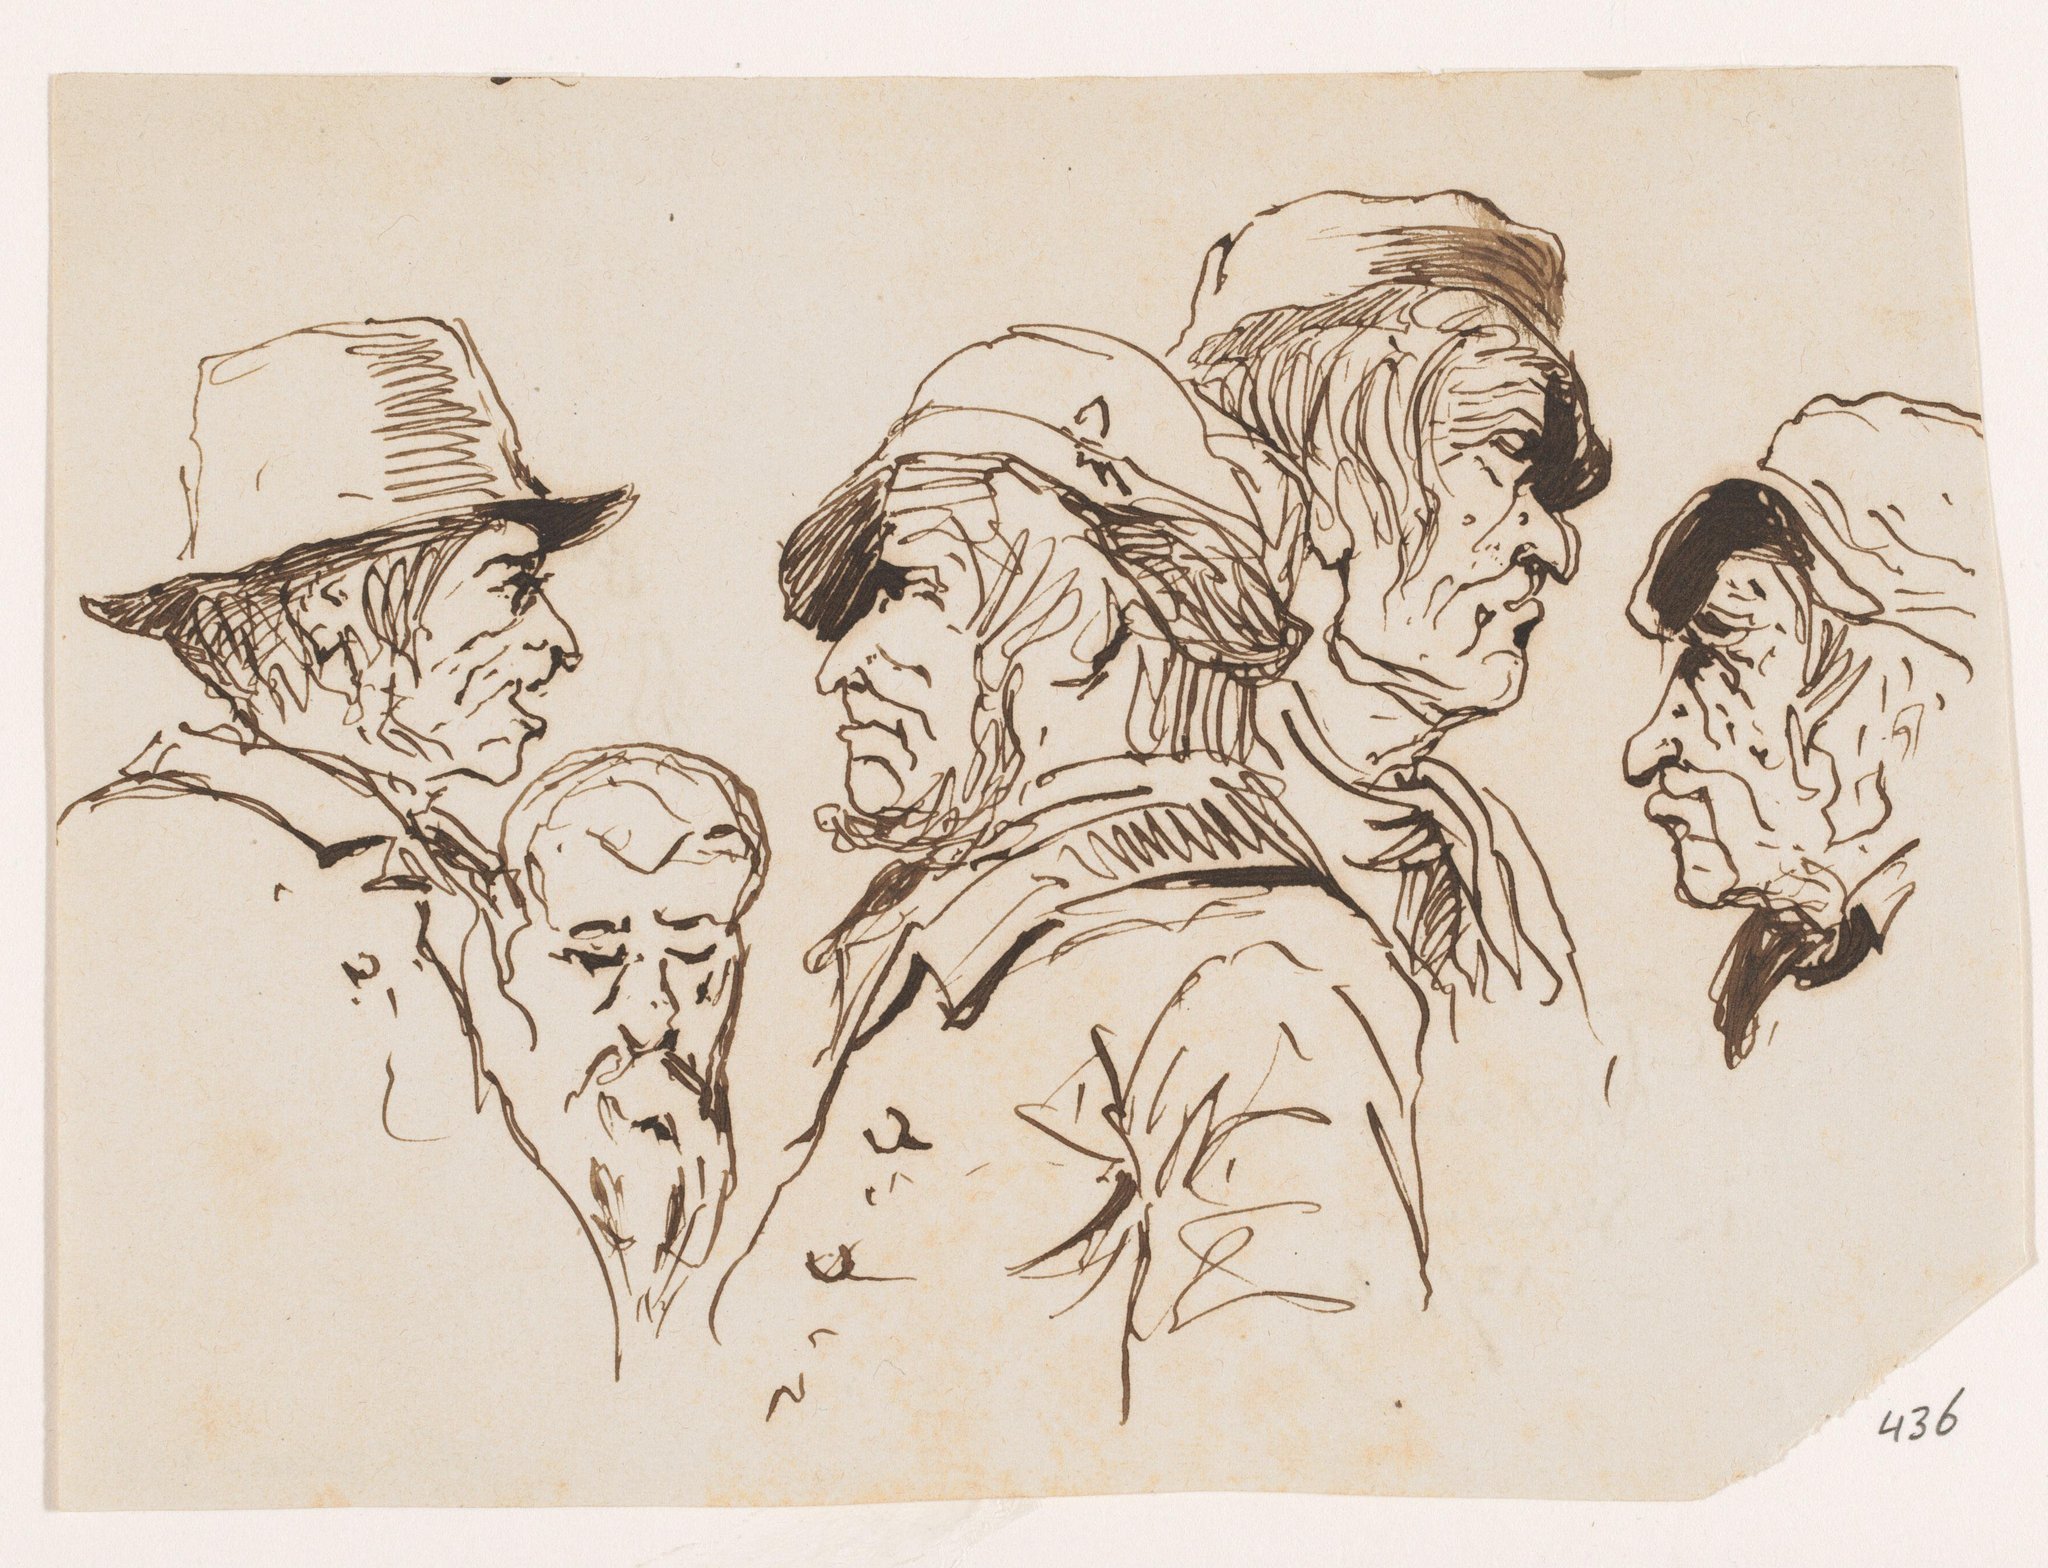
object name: drawing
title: Vijf koppen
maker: johannes tavenraat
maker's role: draughtsman, painter, print maker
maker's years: 1809-1881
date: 1869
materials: ink, paper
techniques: pen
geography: schwerin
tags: caricatures (human types)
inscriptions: collector's mark: Lugt 2228, signature, date and inscription: ‘Tavenraat in Schwerin 12/4 69.’